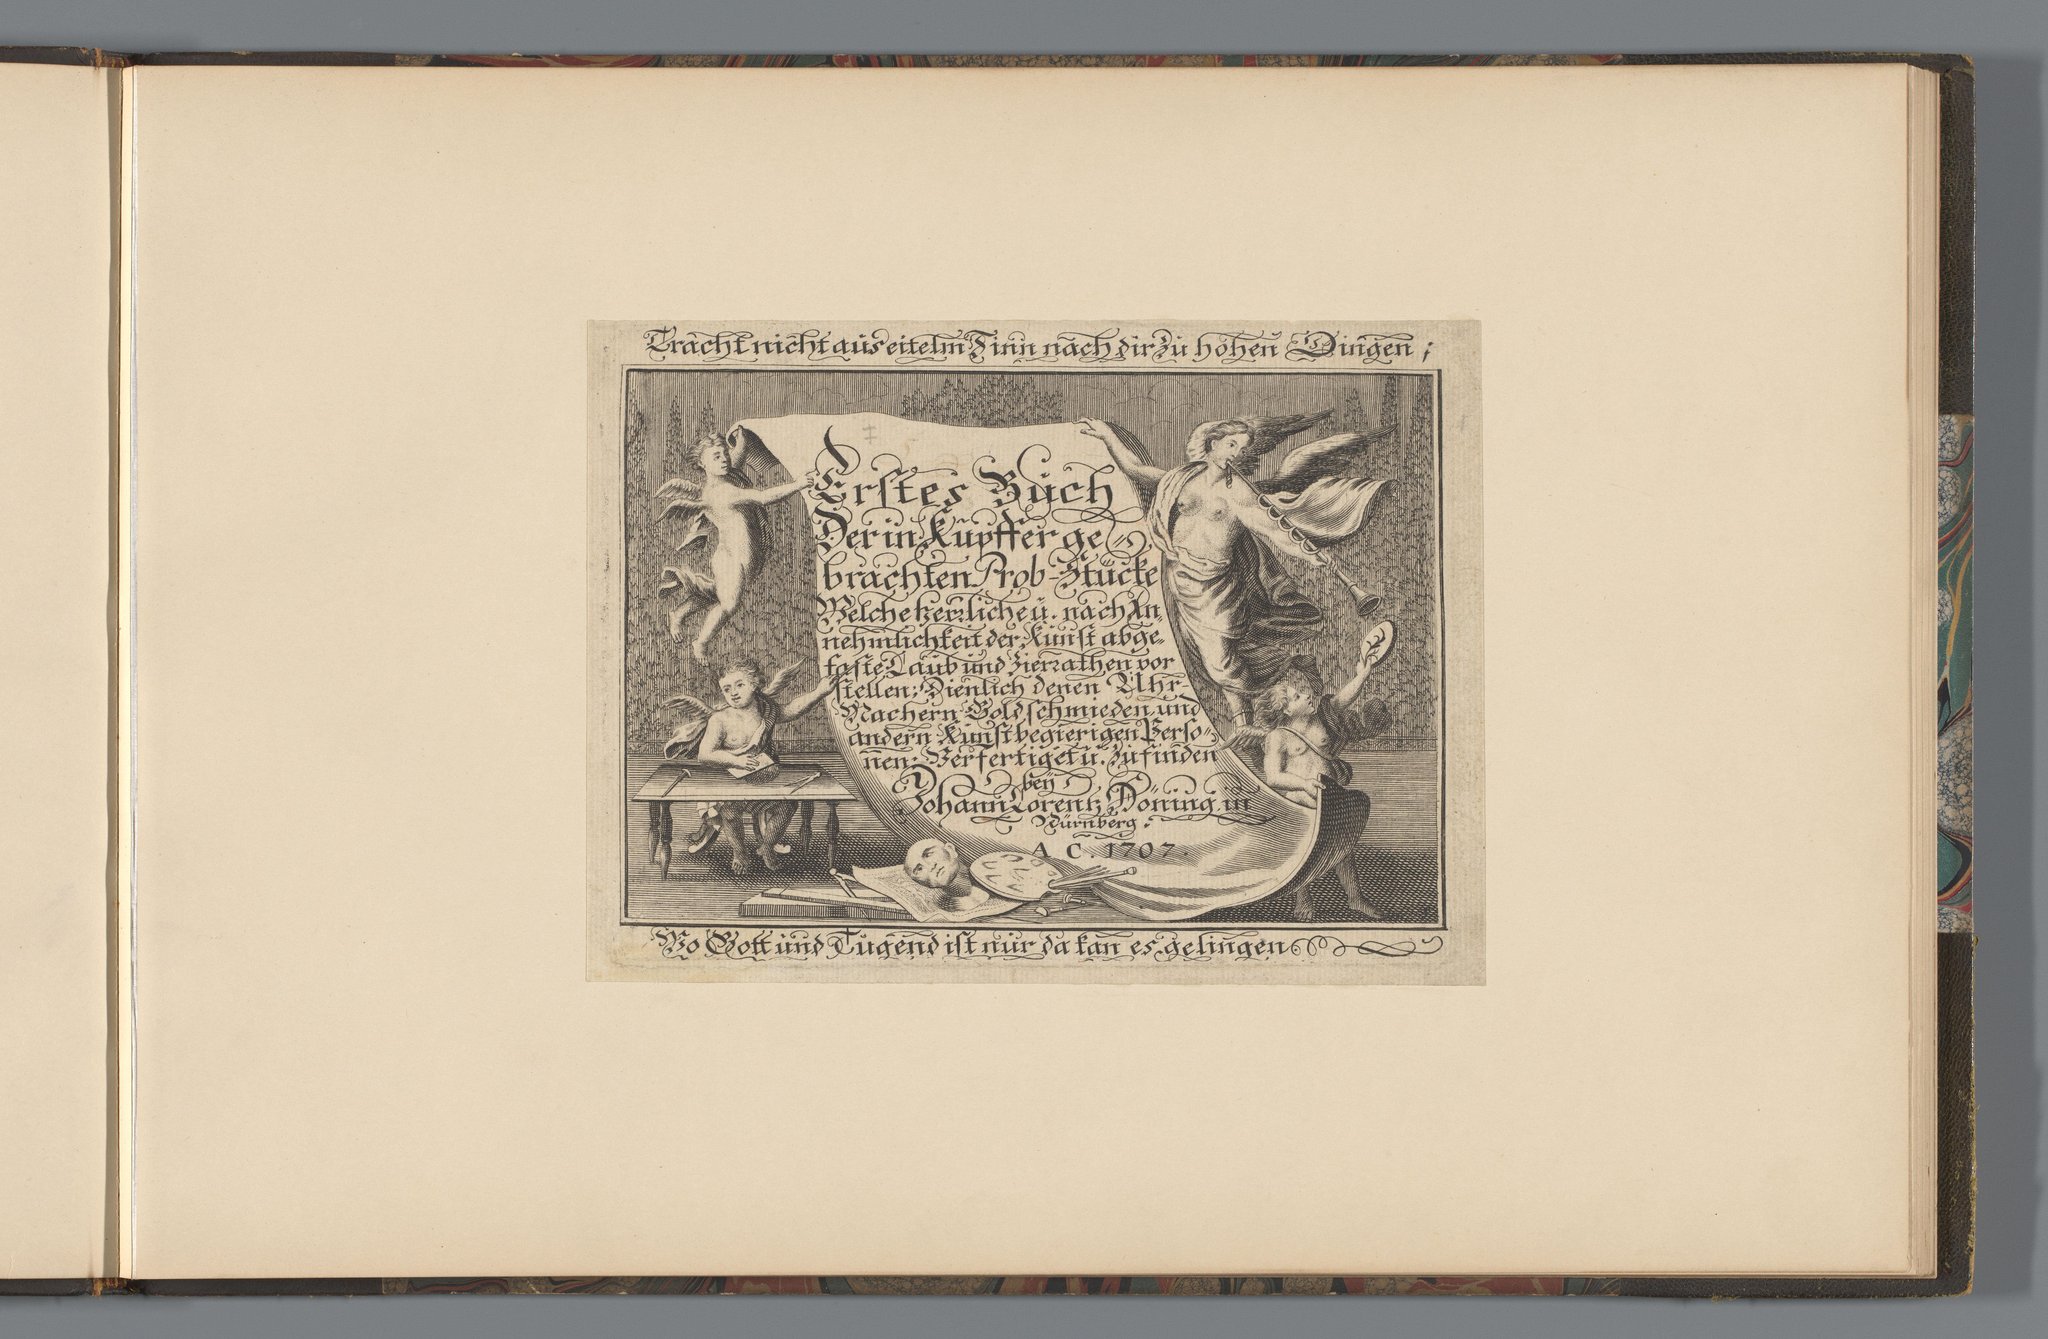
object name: album leaf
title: Titelprent voor een serie ontwerpen voor edelsmeden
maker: johann lorenz hönnig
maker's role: print maker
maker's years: 1674-1713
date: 1707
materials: paper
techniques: engraving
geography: nuremberg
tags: ornaments ~ art, title-page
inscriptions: date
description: Vier engelen houden een aankondiging omhoog met daarop de tekst. Vooraan liggen kunstenaarsbenodigdheden zoals een palet en een passer. Prent maakt deel uit van een album.